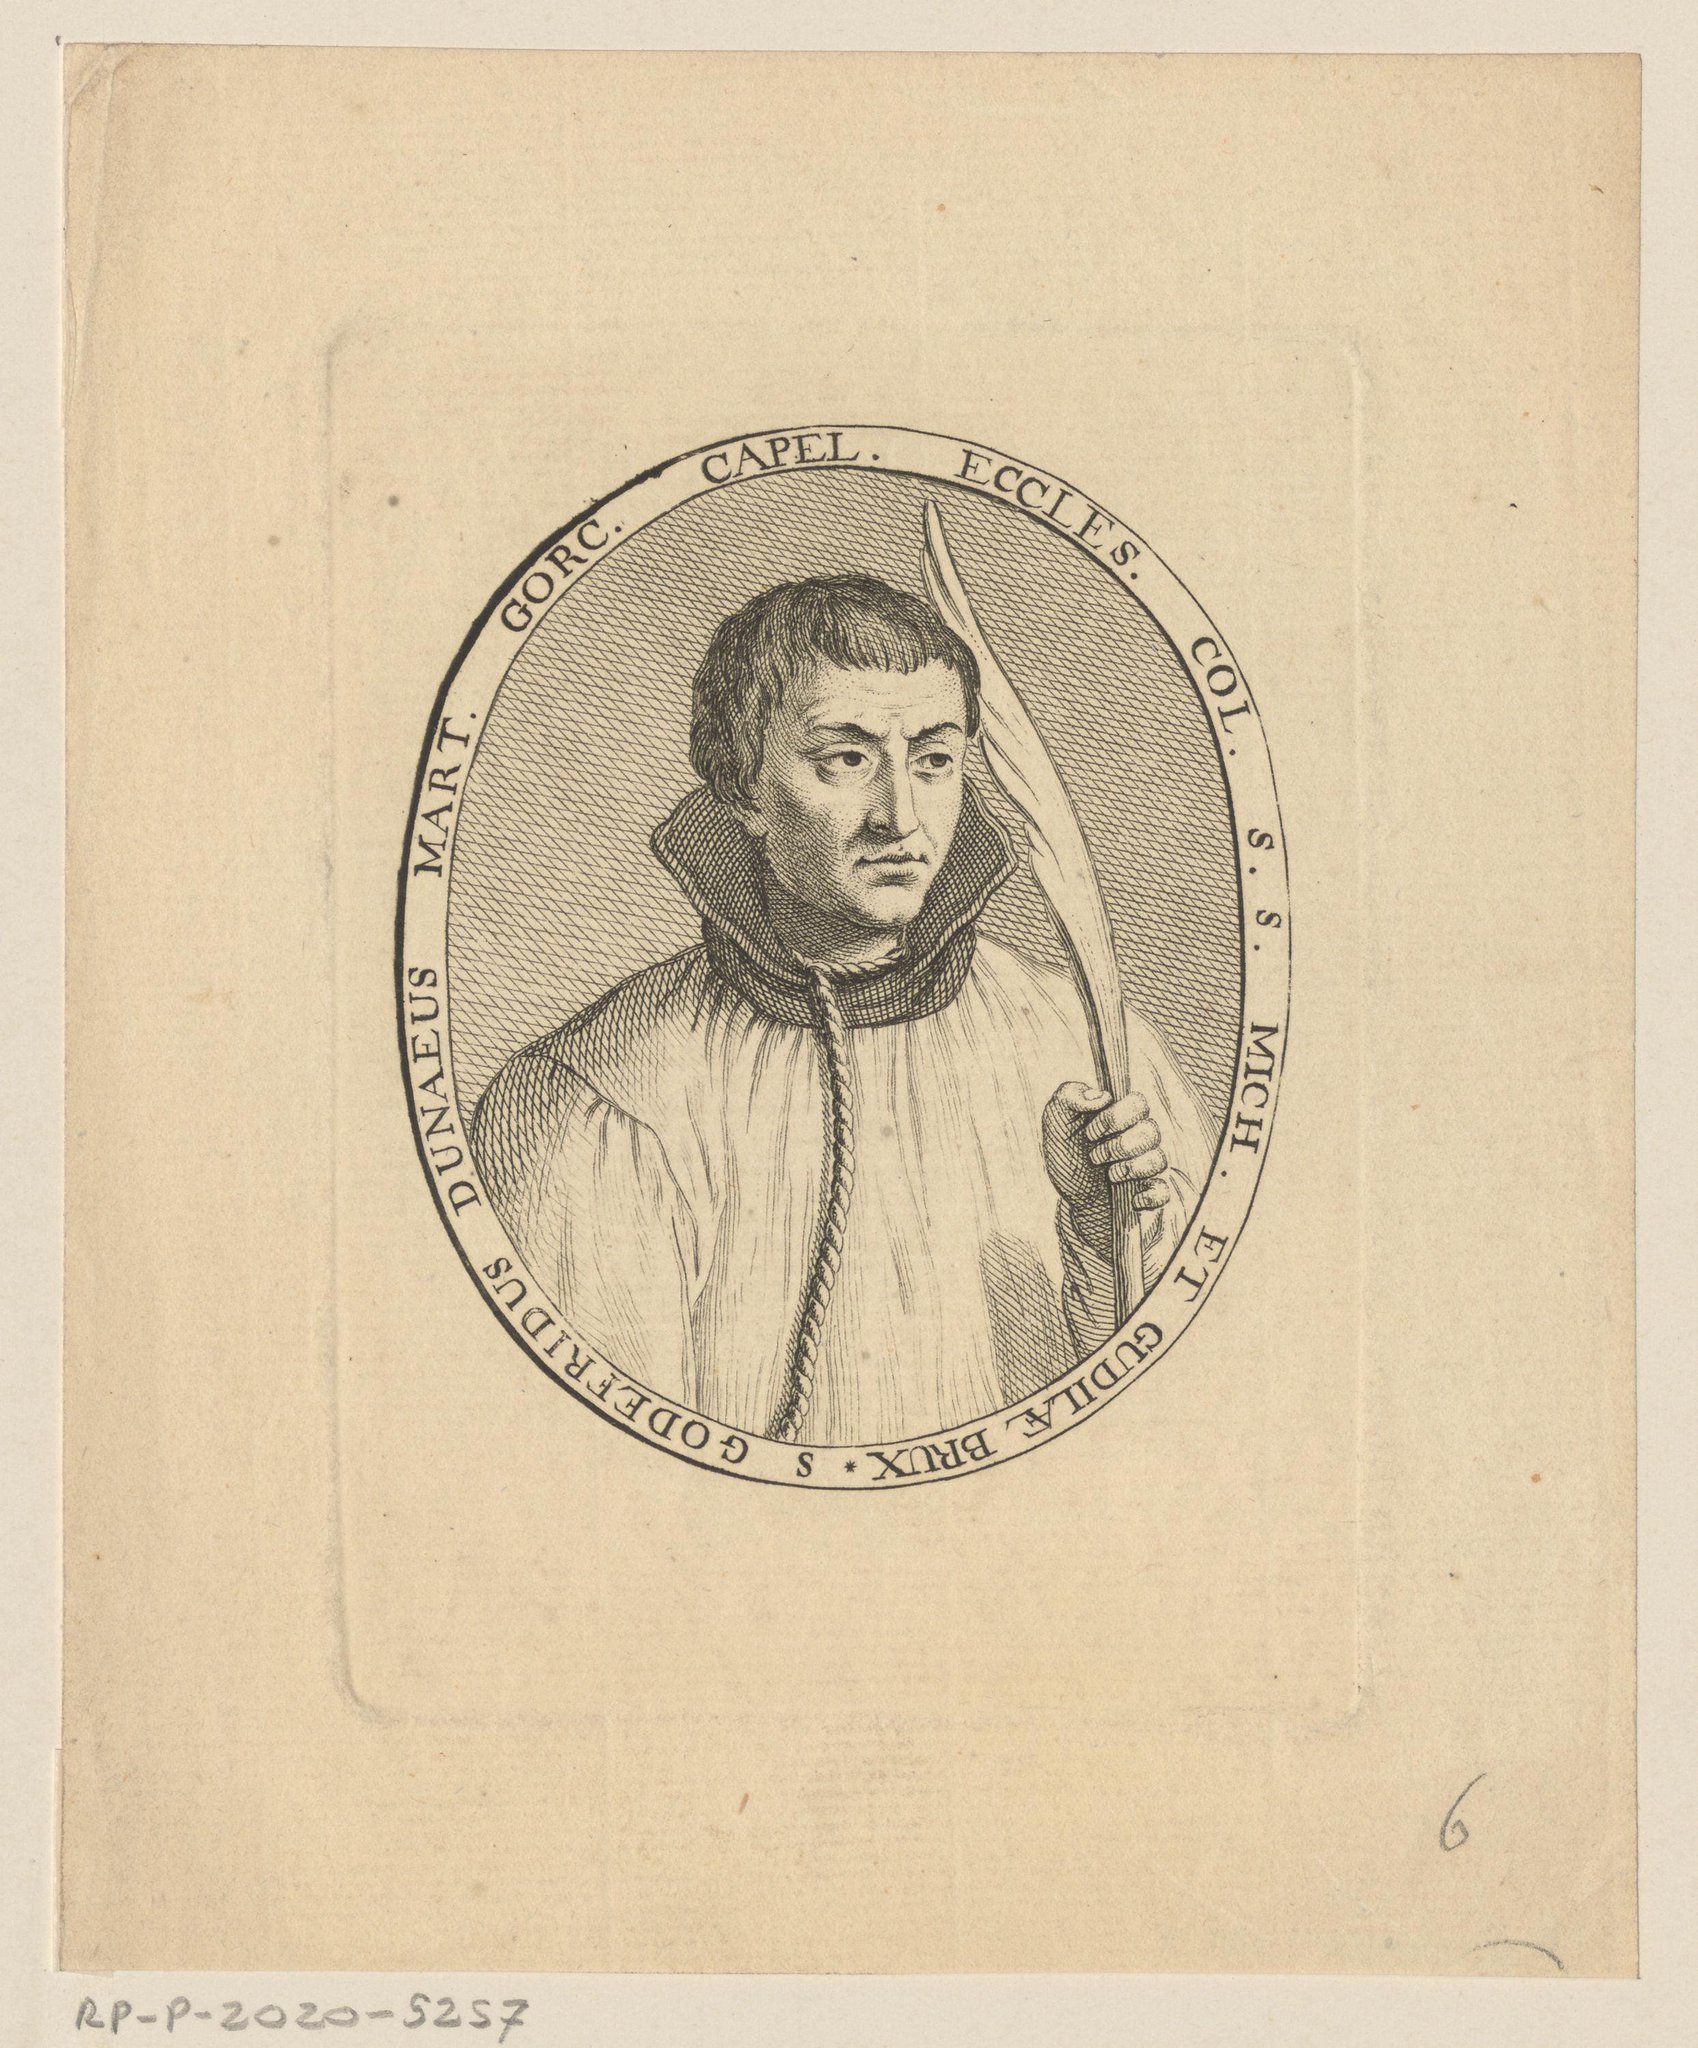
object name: print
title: Portret van Godfried van Duynen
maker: Anonymous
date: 1777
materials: paper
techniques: engraving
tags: brielle, historical persons, priests ~ hierarchy of priests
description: Prent mogelijk uit: Rombout, J.A. Het verheerlykt of opgehelderd Brussel (...). Brussel: Gérard Pauwels, 1777.